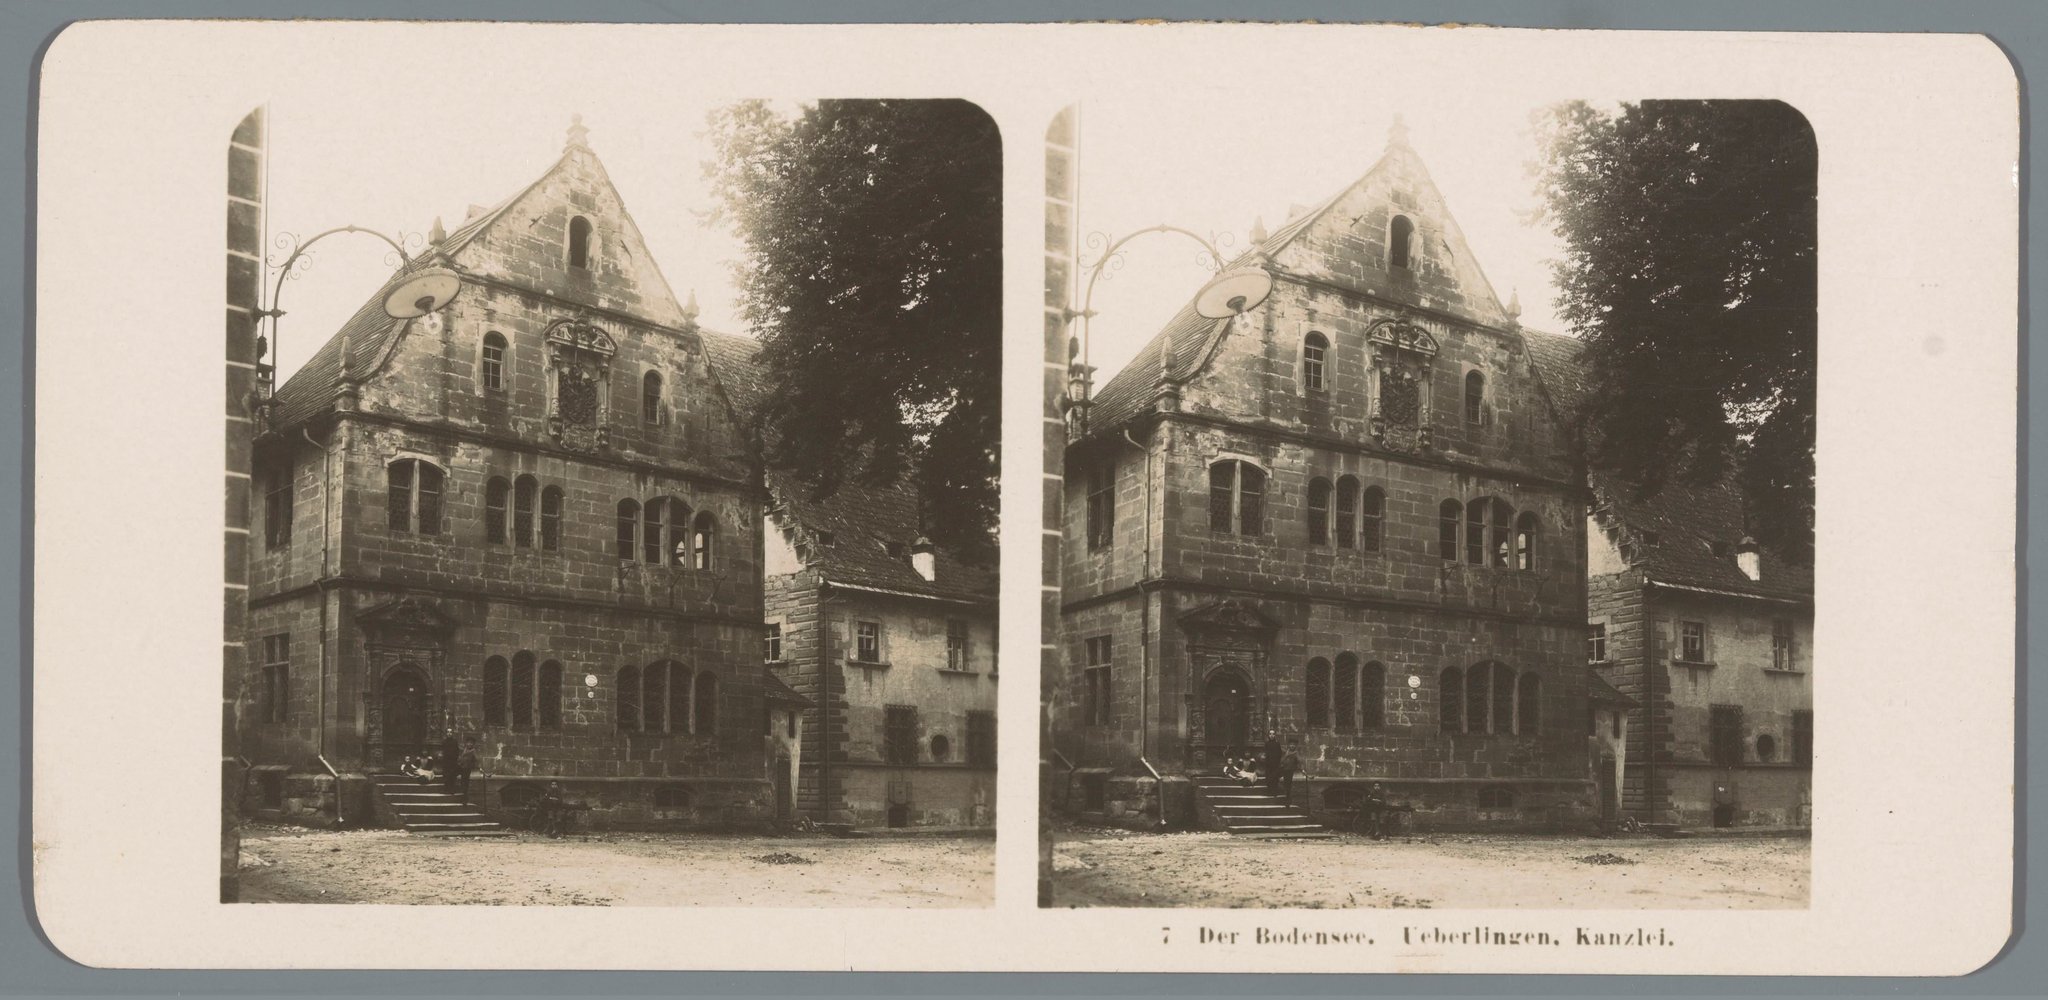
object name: stereograph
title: Voorgevel van de kanselarij van Überlingen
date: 1906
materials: cardboard, photographic support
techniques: gelatin silver print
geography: uberlingen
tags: housing, façade (of house or building)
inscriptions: number: ‘7’, inscription: ‘Neue Photographische Gesellschaft A. G., Steglitz-Berlin 1906.’